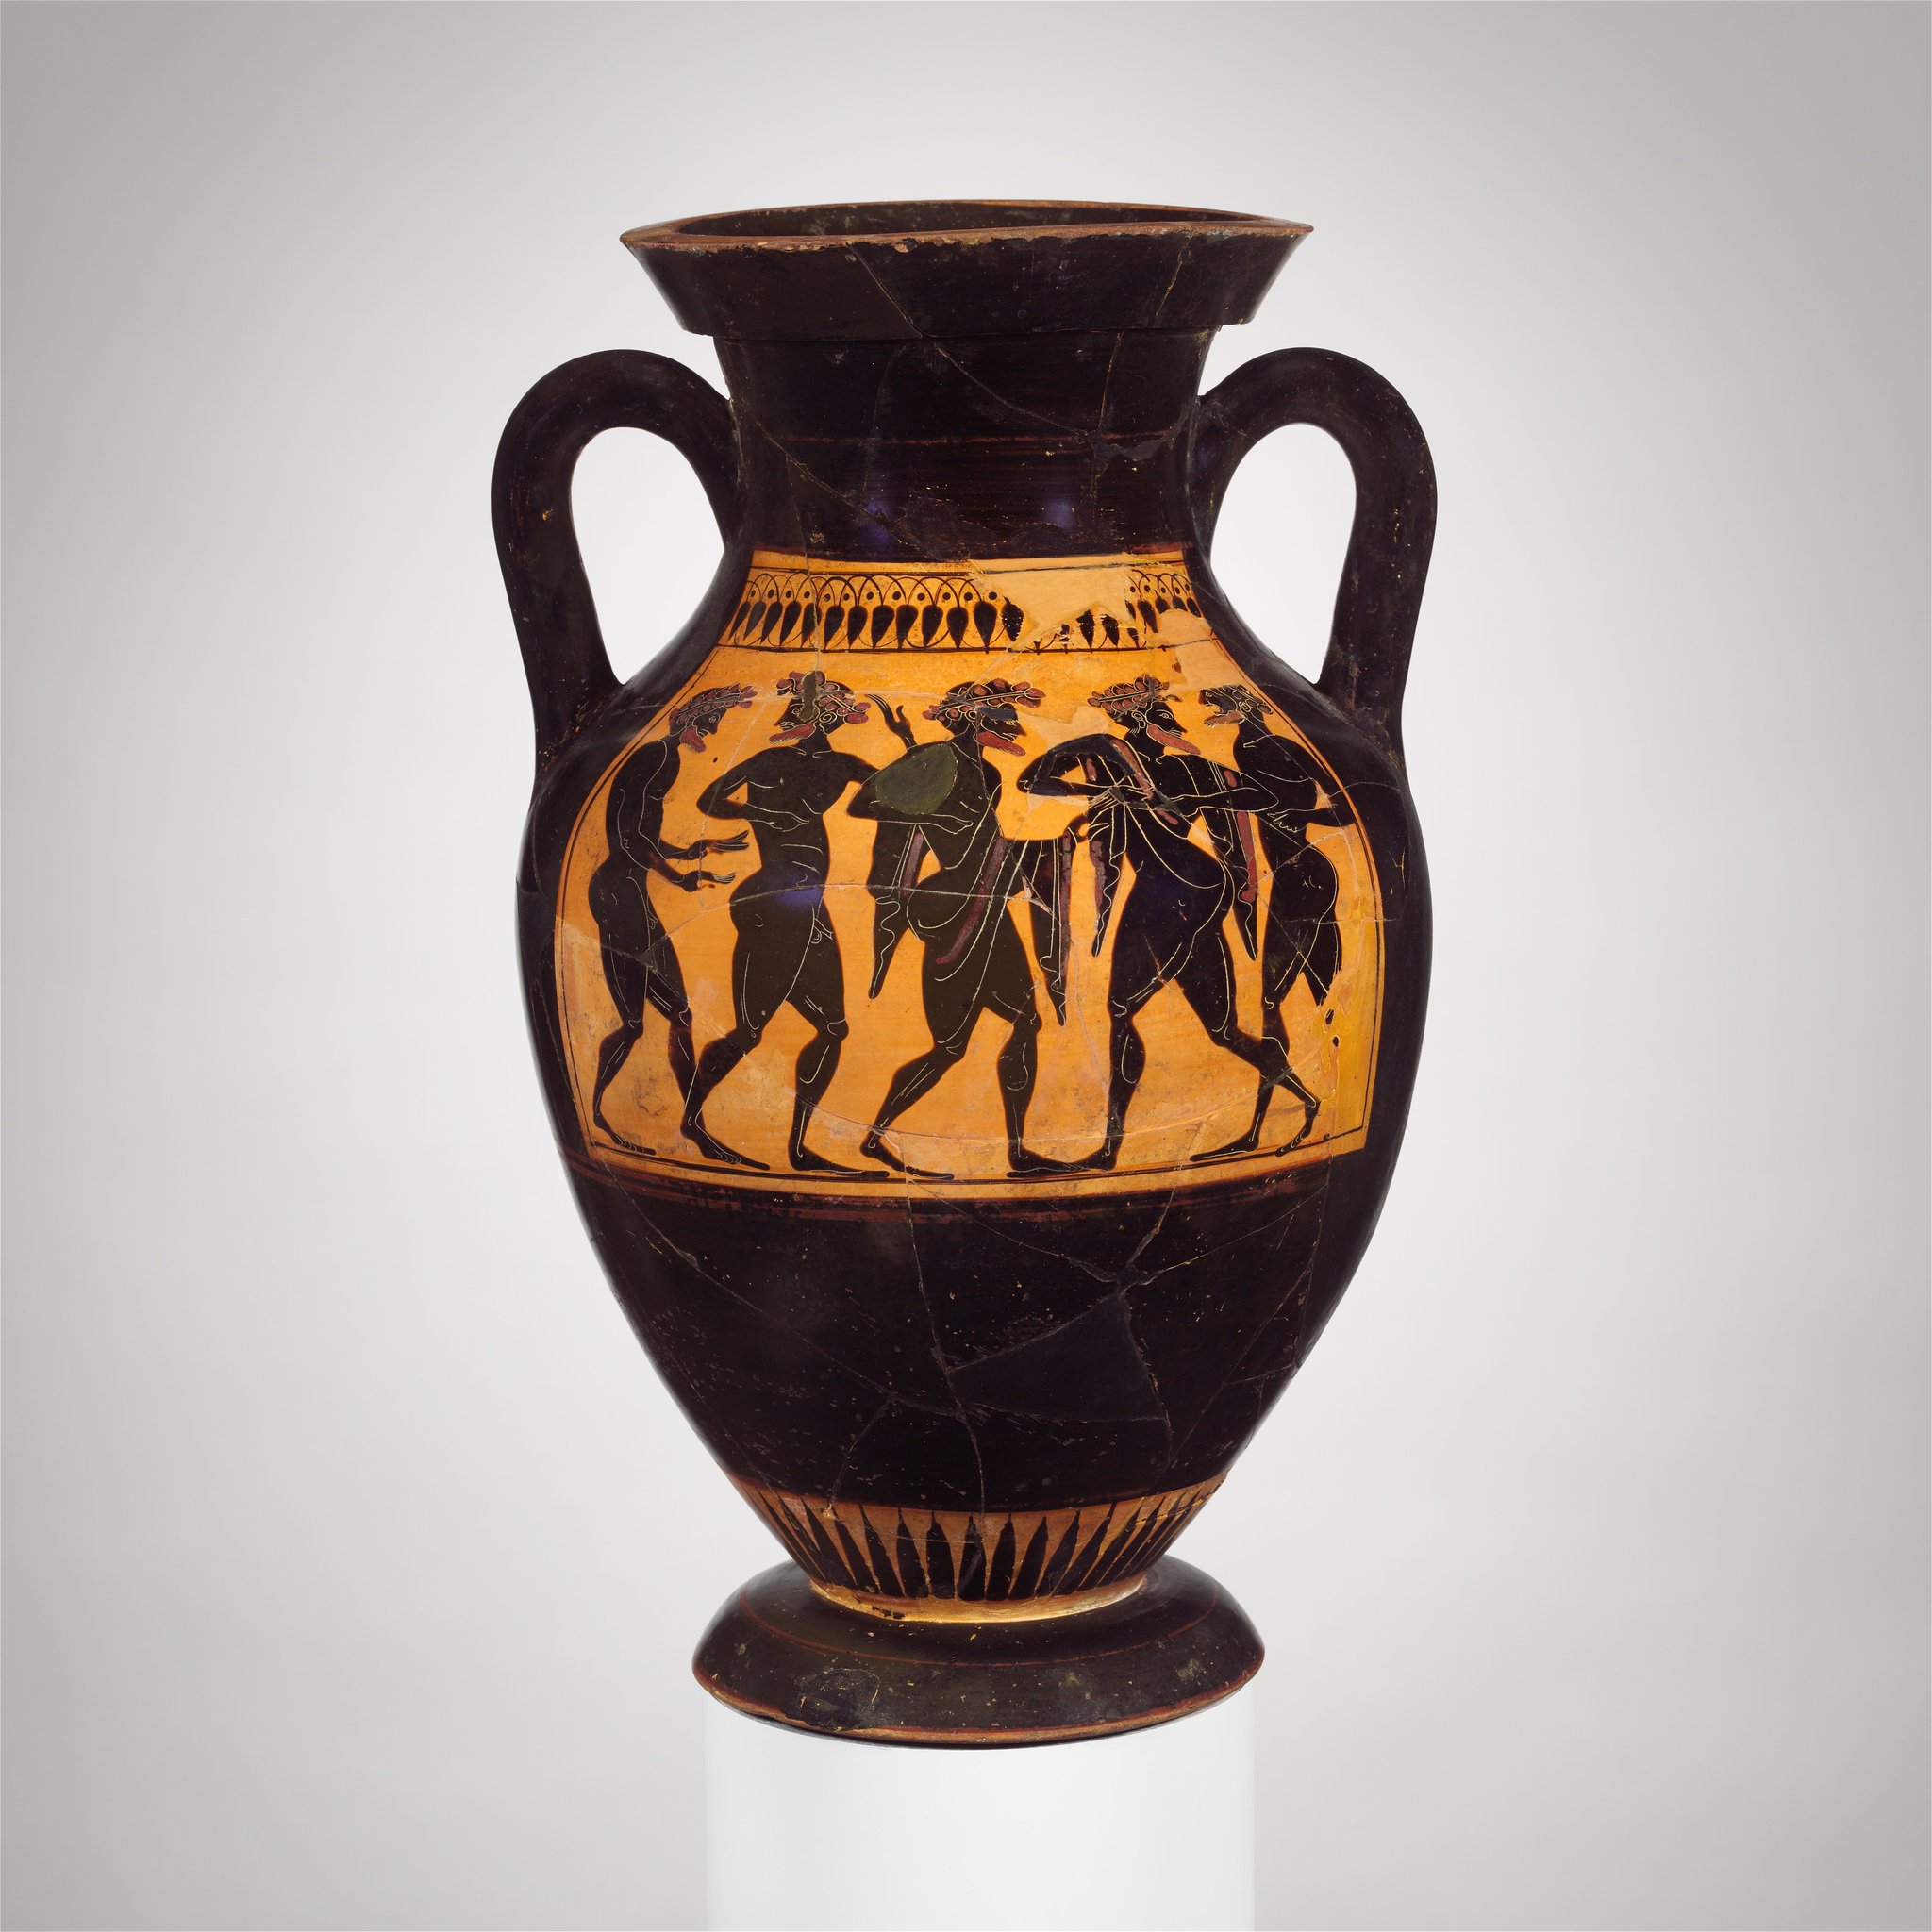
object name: amphora, type b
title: Terracotta amphora (jar)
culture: greek, attic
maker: acheloös painter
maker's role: artist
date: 520-510 BCE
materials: terracotta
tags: men,wreaths